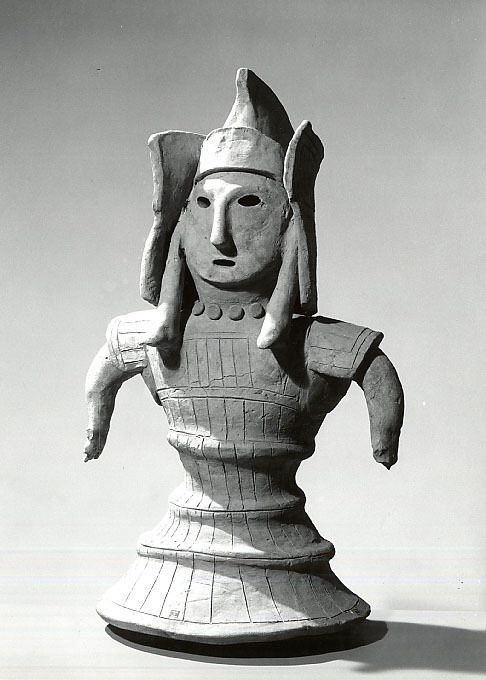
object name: haniwa figure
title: Haniwa Figure of a Warrior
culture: japanese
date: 501-600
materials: earthenware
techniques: incising, painting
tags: men